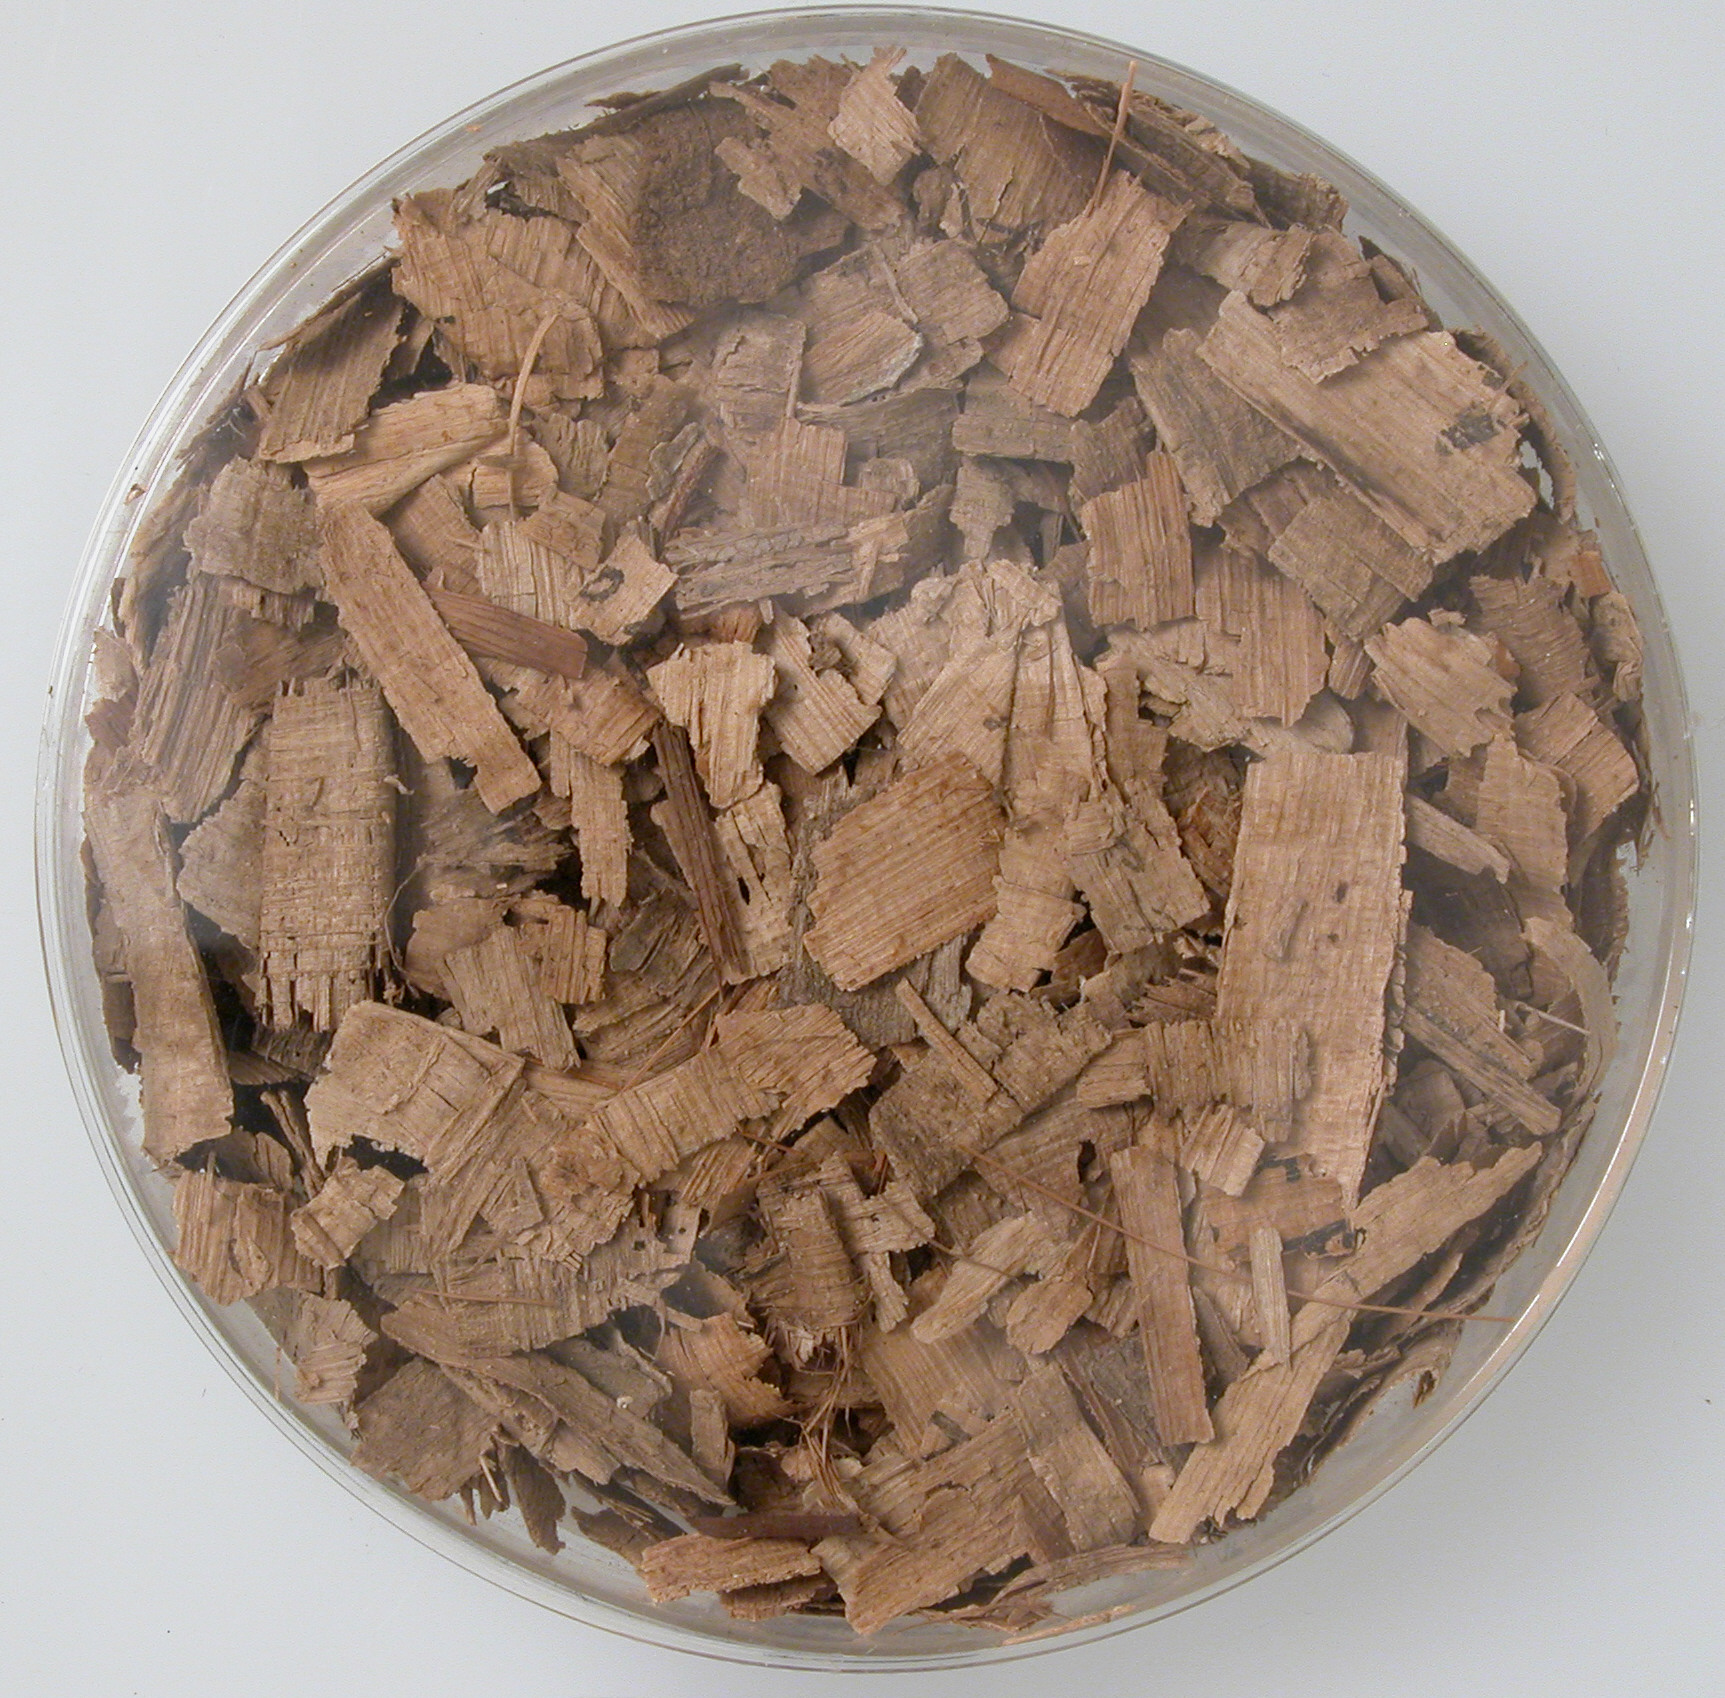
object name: fragment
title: Papyri Fragments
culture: coptic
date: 601-700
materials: ink, papyrus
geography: egypt